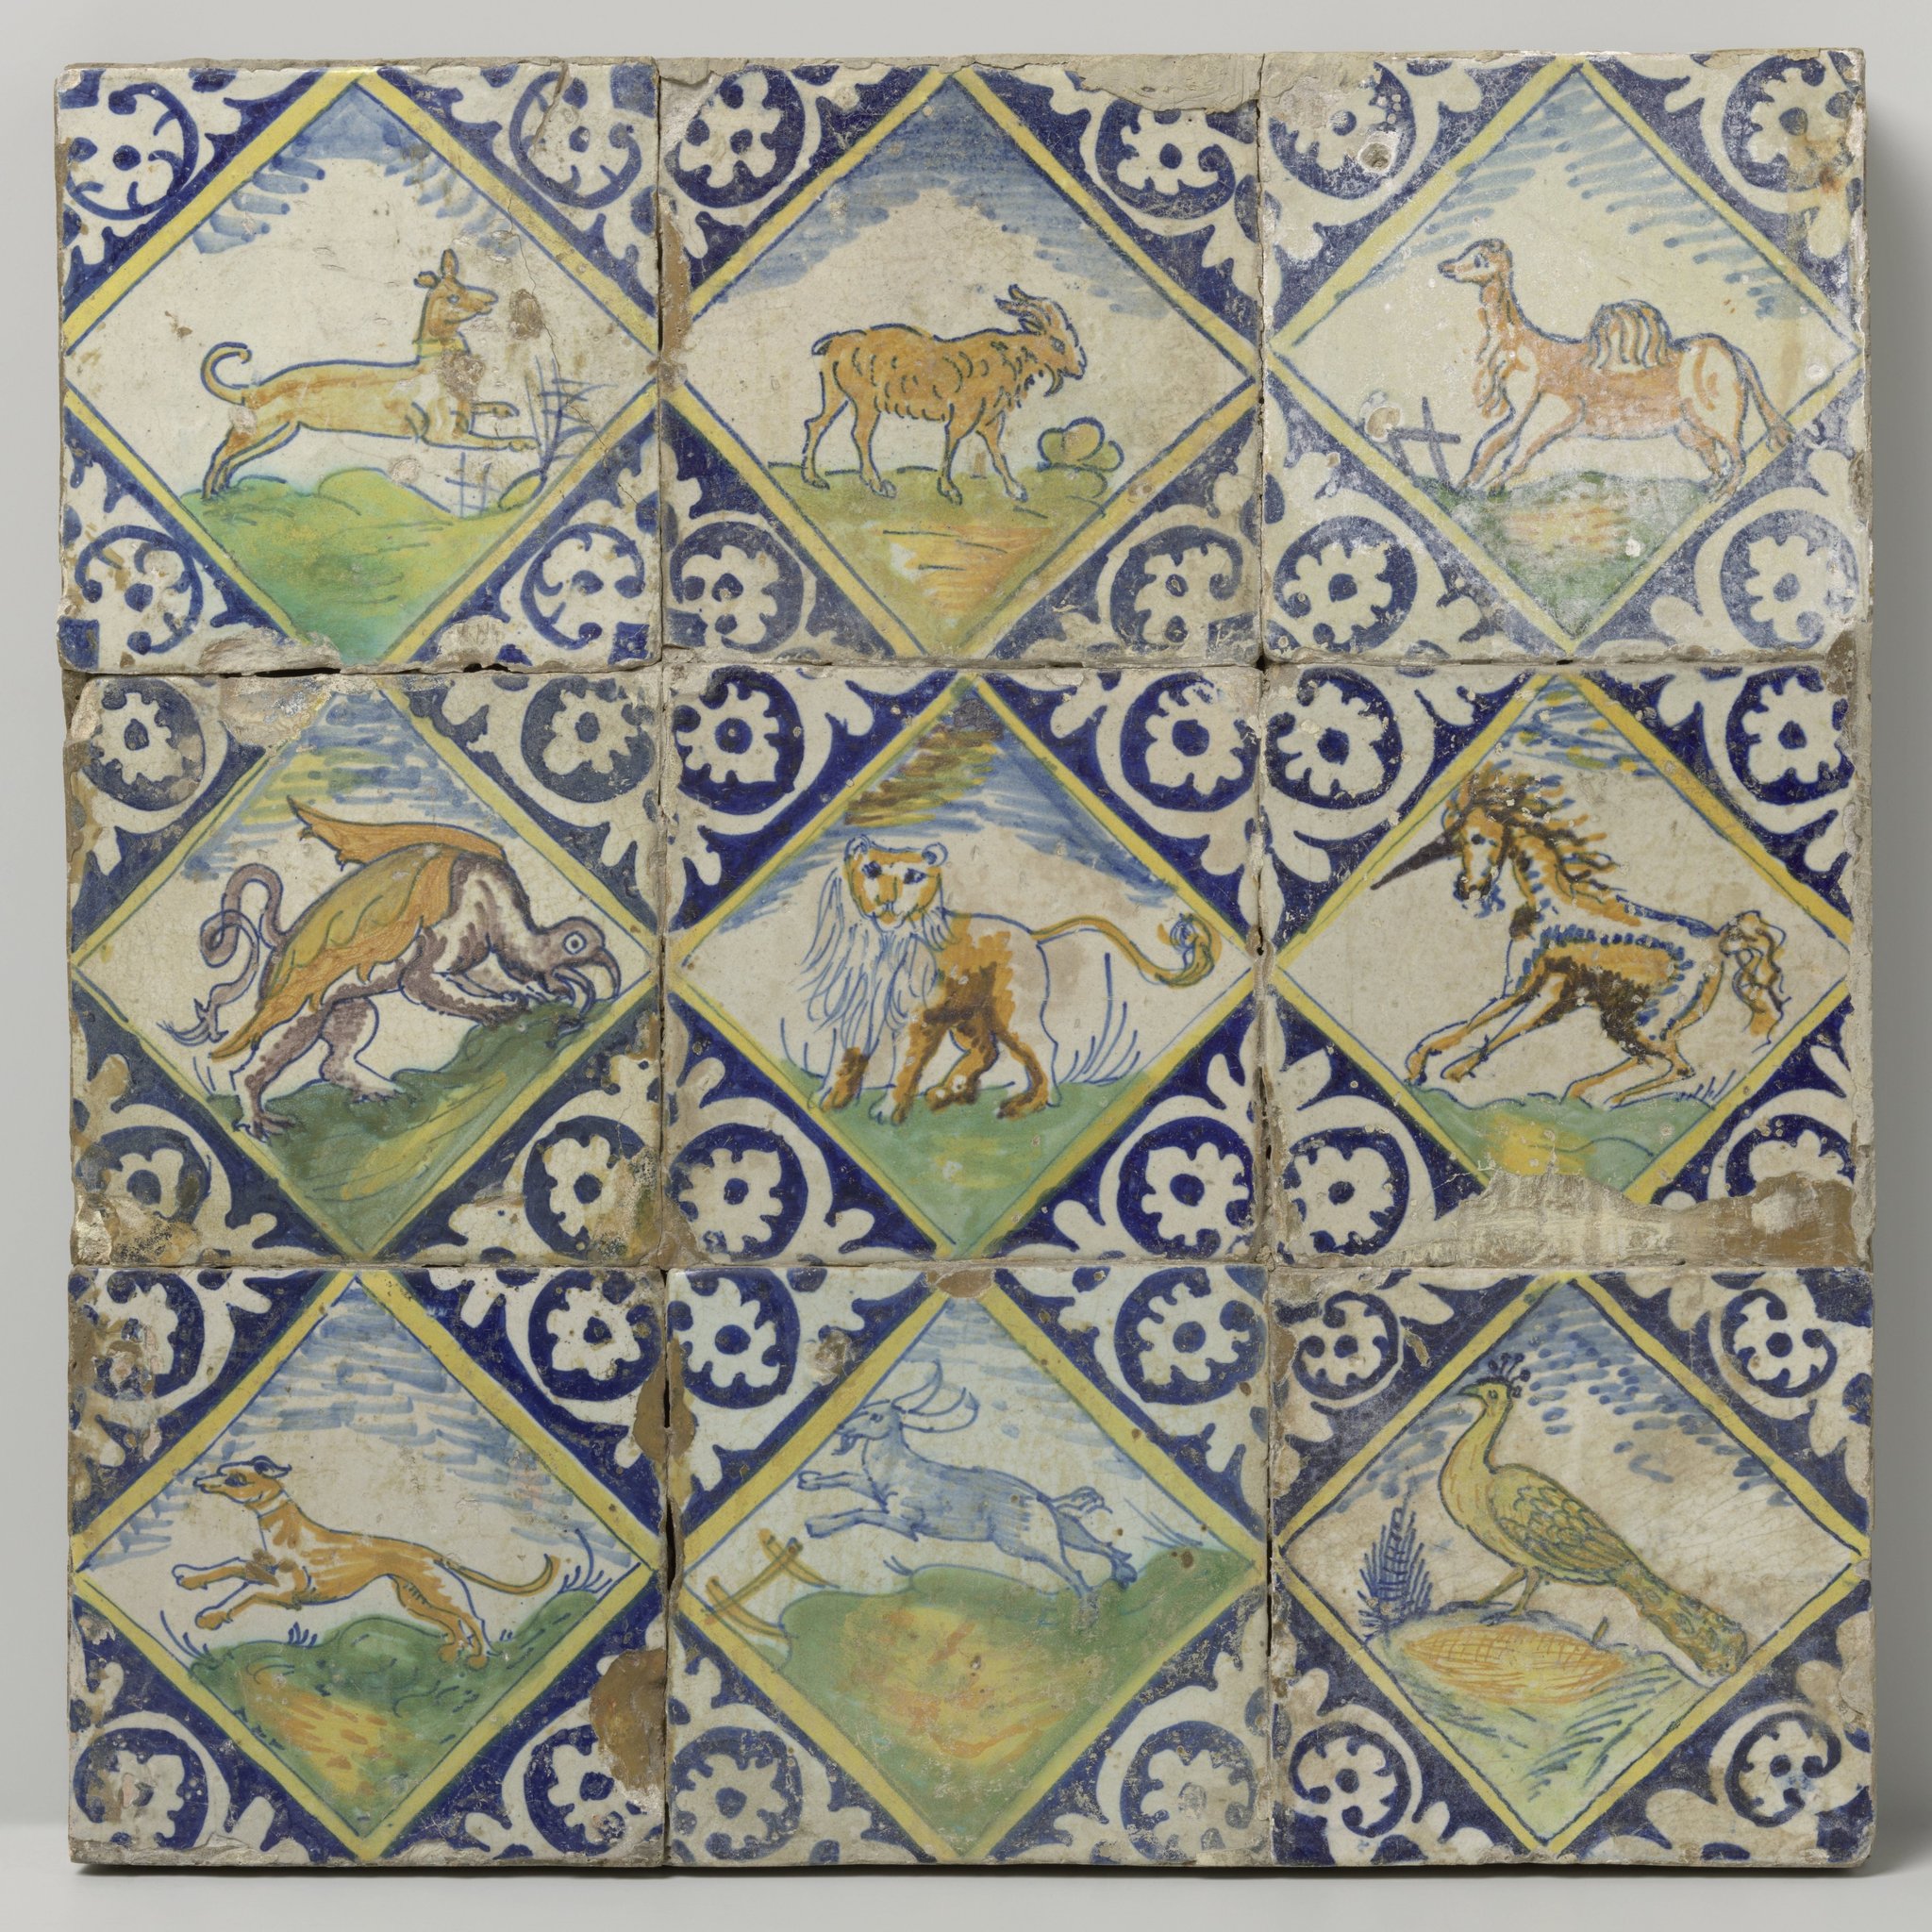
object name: tile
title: Veld van negen tegels met dieren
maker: Anonymous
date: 1580-1625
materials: earthenware, glaze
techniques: maiolica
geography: netherlands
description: Veld van negen tegels (3 x 3) elk met een veelkleurig (blauw, oranje, geel, groen en paars) geschilderd dier op een grond binnen een kwadraat omlijsting. In de hoeken, ornament in vultechniek.